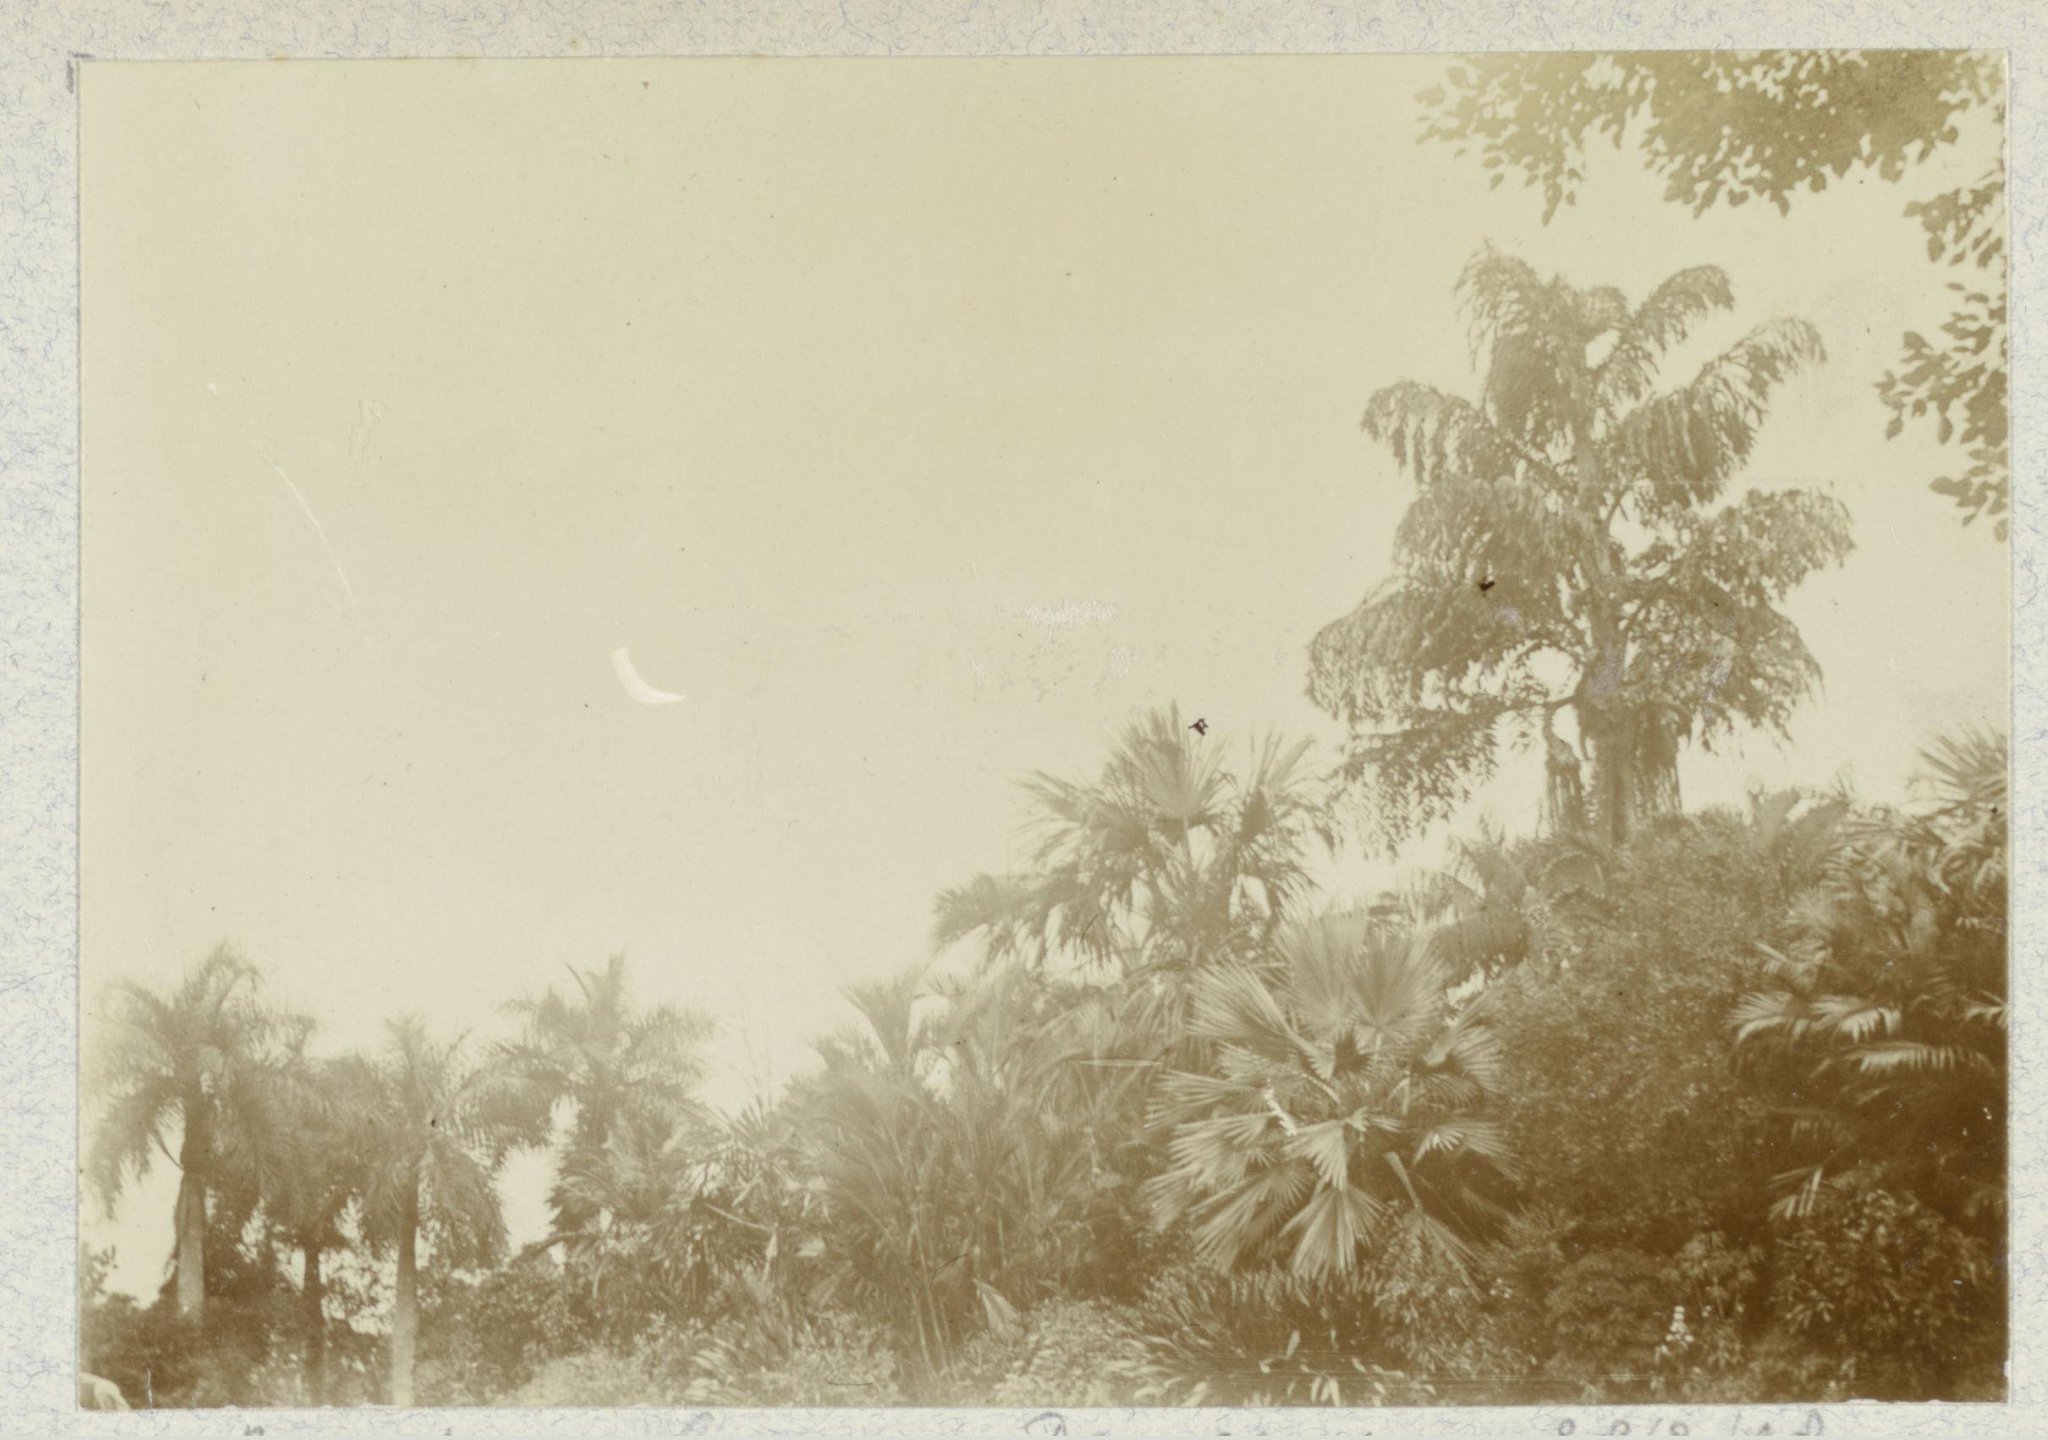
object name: photograph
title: Botanische Tuinen in Demerary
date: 1908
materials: photographic support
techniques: photography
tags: amsterdam, andries augustus boom, botanic garden, 'hortus botanicus'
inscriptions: inscription: ‘Botanical Garden. Demerara 28/03/08.’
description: Botanische Tuinen in Demerary (Demerara), 28 maart 1908. Onderdeel van het fotoalbum van de familie Boom-Gonggrijp in Suriname en Curaçao.